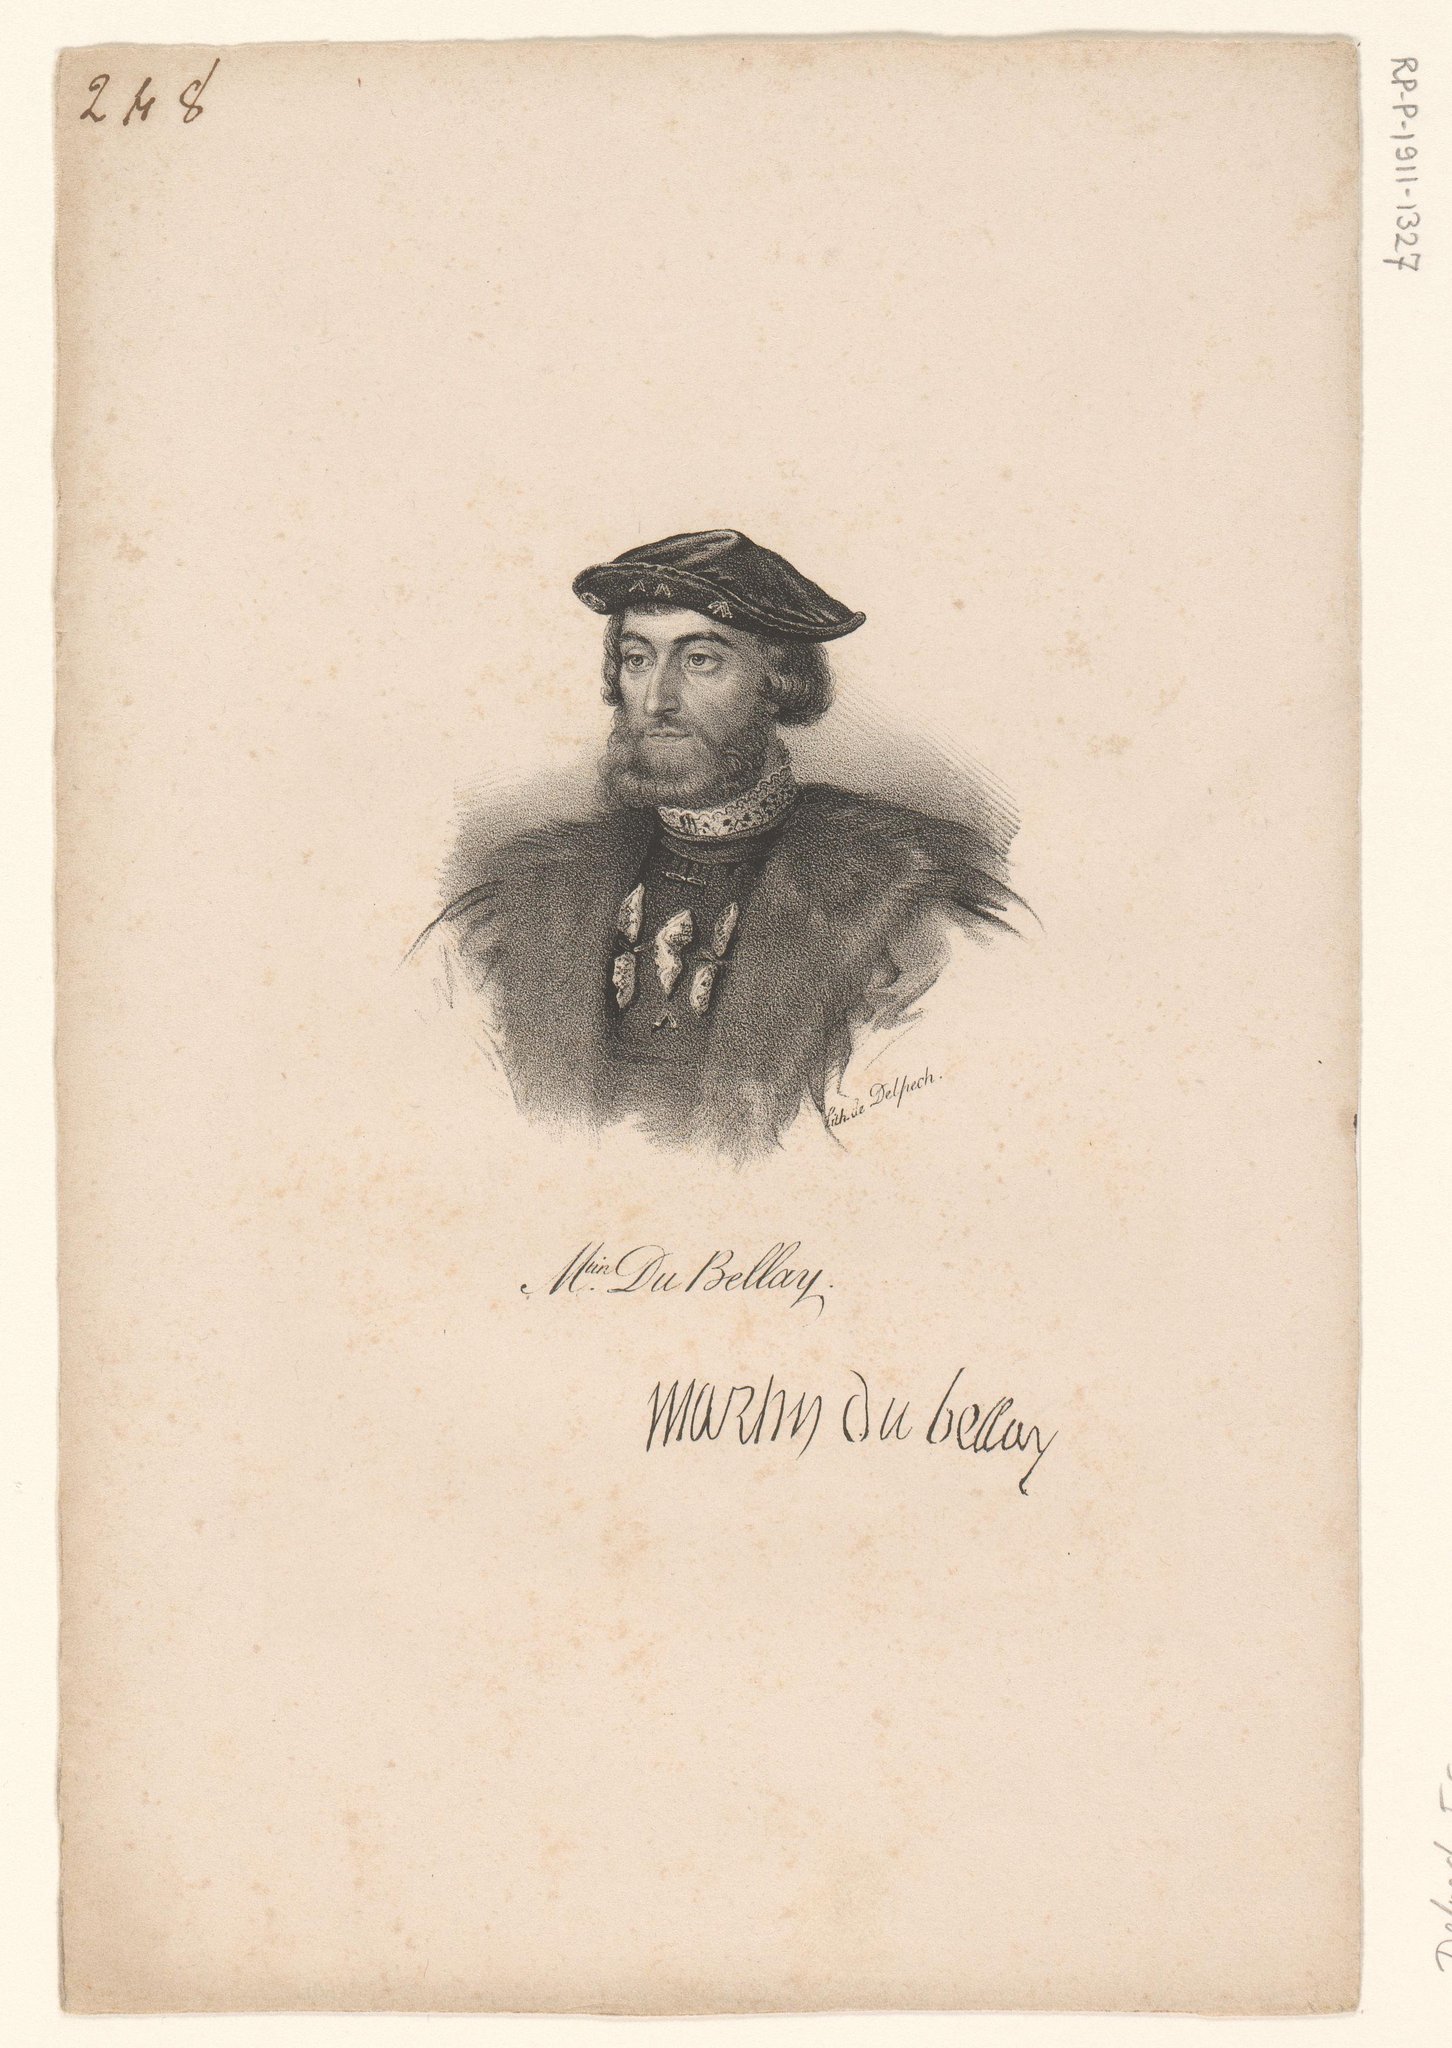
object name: print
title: M.tin Du Bellay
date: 1818-1842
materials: paper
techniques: lithograph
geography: paris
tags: historical persons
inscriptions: collector's mark: Lugt 2228a